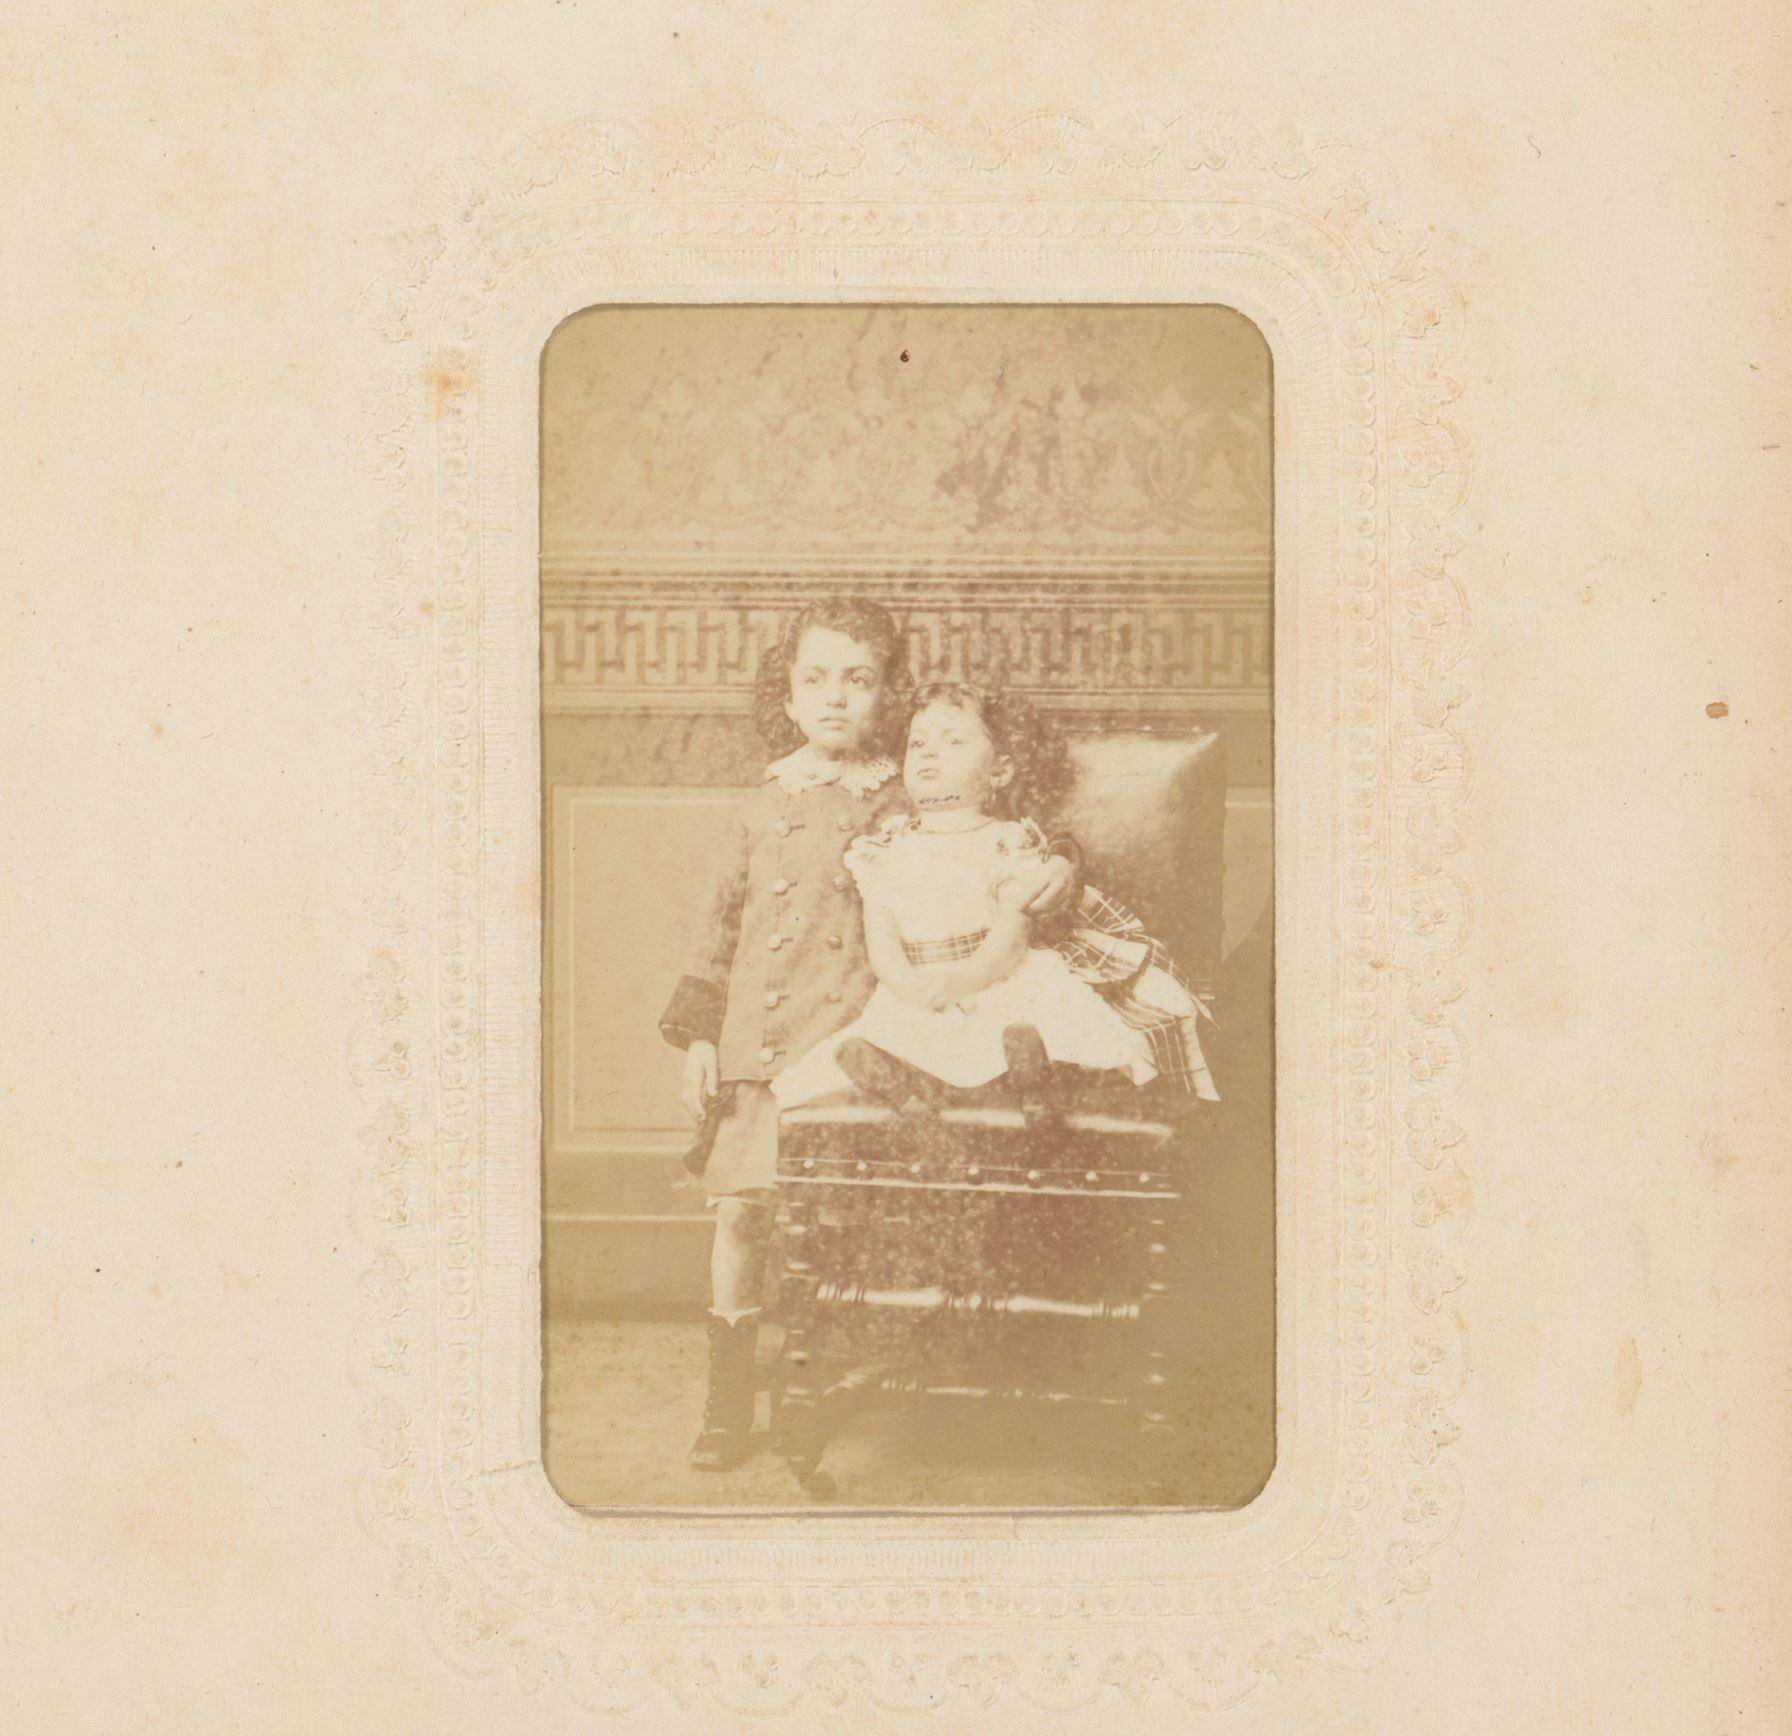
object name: carte de visite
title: Portret van twee meisjes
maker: eugene guérin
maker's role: fotograaf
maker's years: 1845-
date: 1868-1876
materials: cardboard, photographic support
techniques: albumen print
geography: brussels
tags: historical persons - bb - woman, girl (child between toddler and youth)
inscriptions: inscription: ‘Eugène Guérin/ Bruxelles. 32, Rue de Louvain’